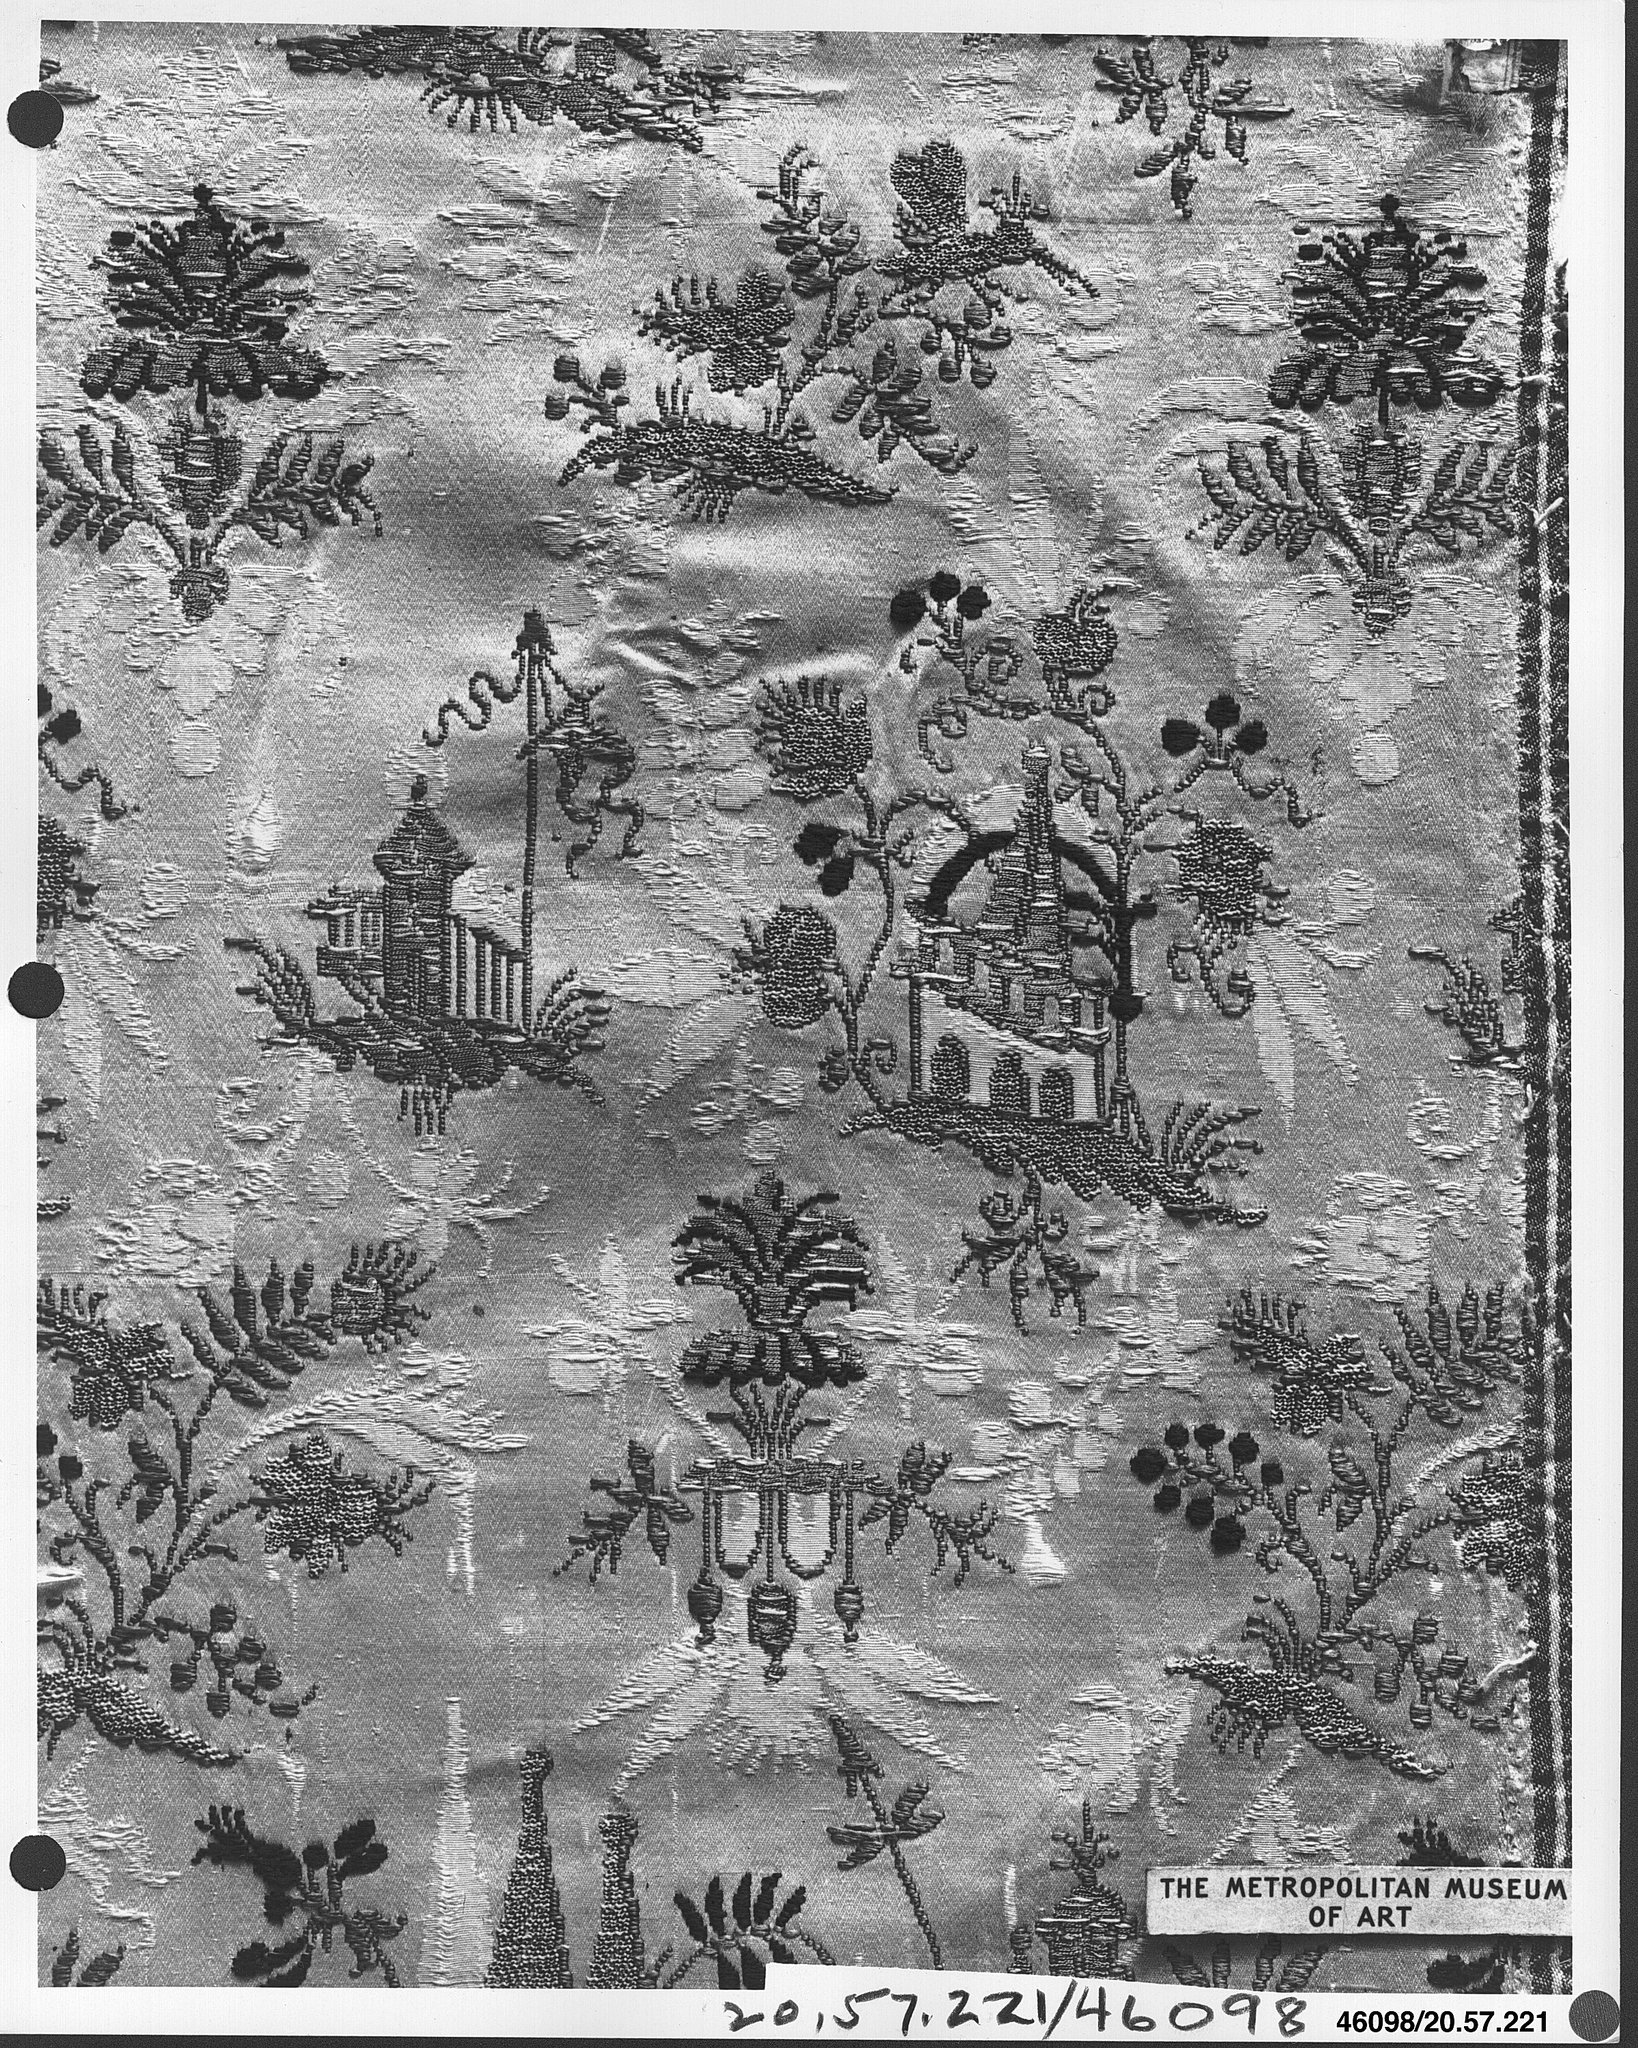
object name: piece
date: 1701-1800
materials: silk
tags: buildings,flowers